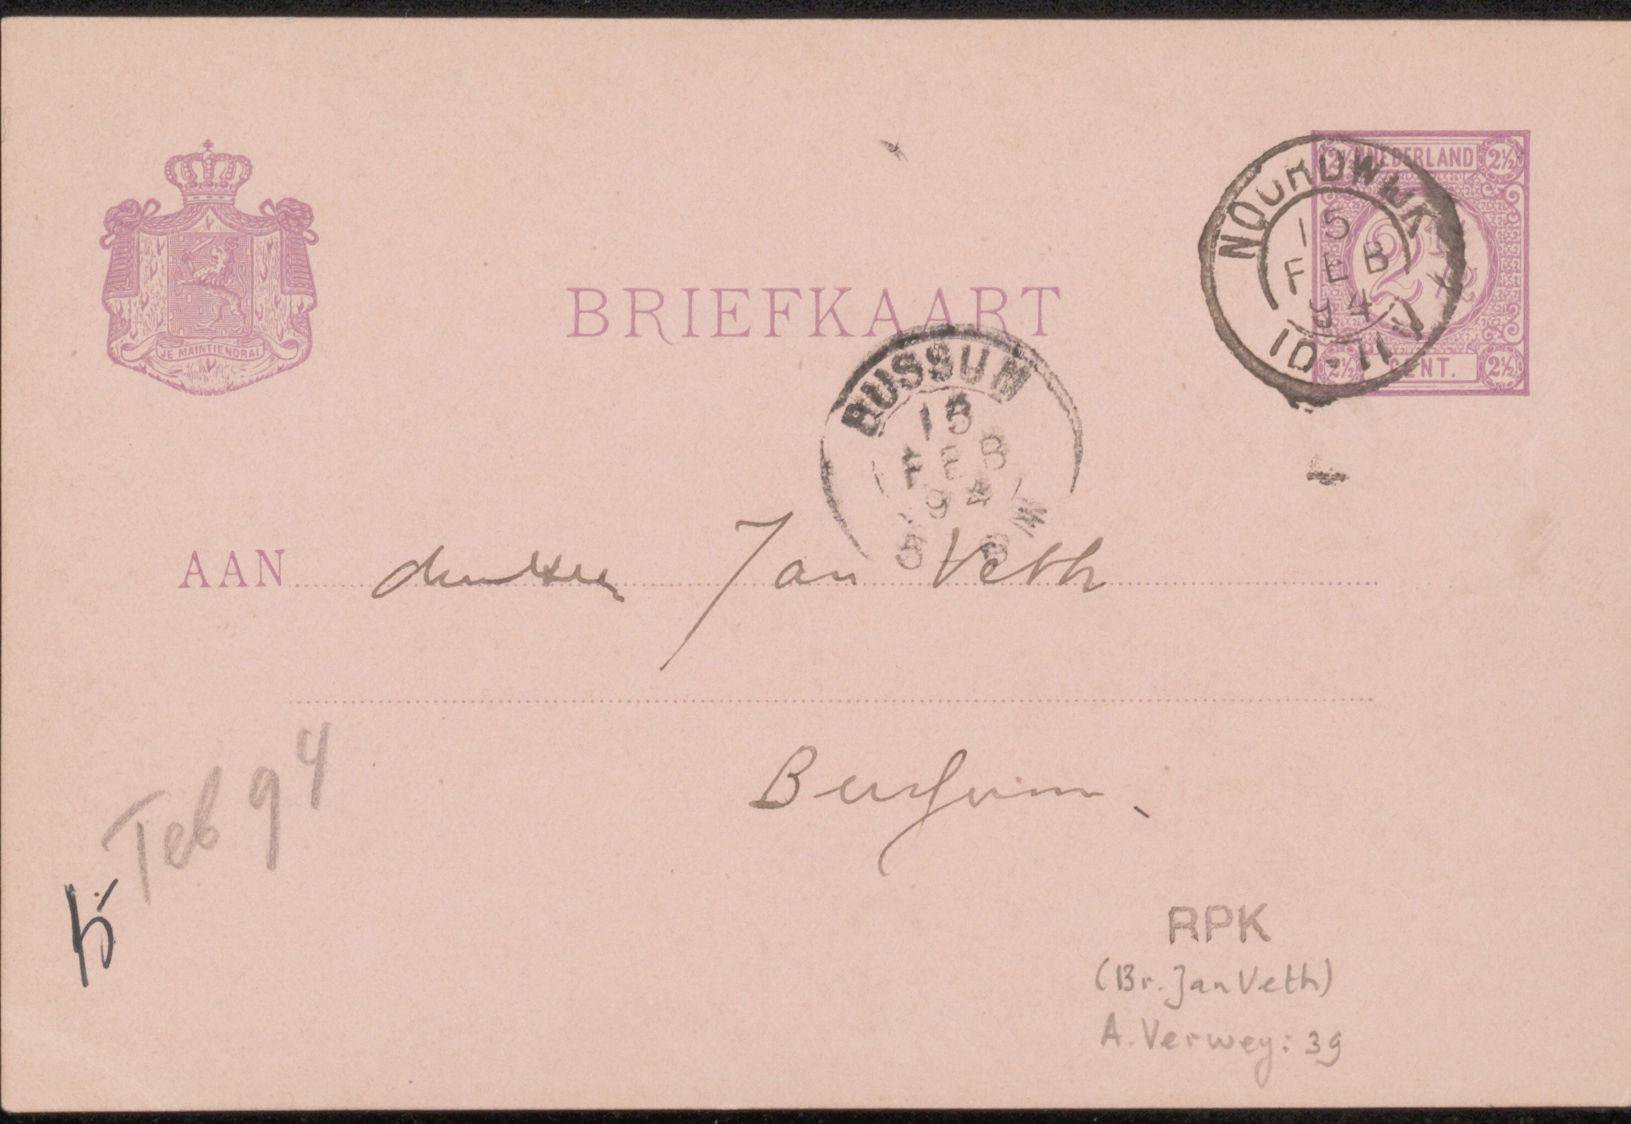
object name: postcard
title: Briefkaart aan Jan Veth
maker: albert verwey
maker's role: criticus, dichter, essayist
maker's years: 1865-1937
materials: cardboard, ink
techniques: pen, writing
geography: noordwijk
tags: dordrecht, painter, print maker, draughtsman, designer, jan veth, family life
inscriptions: collector's mark: ‘RPK’